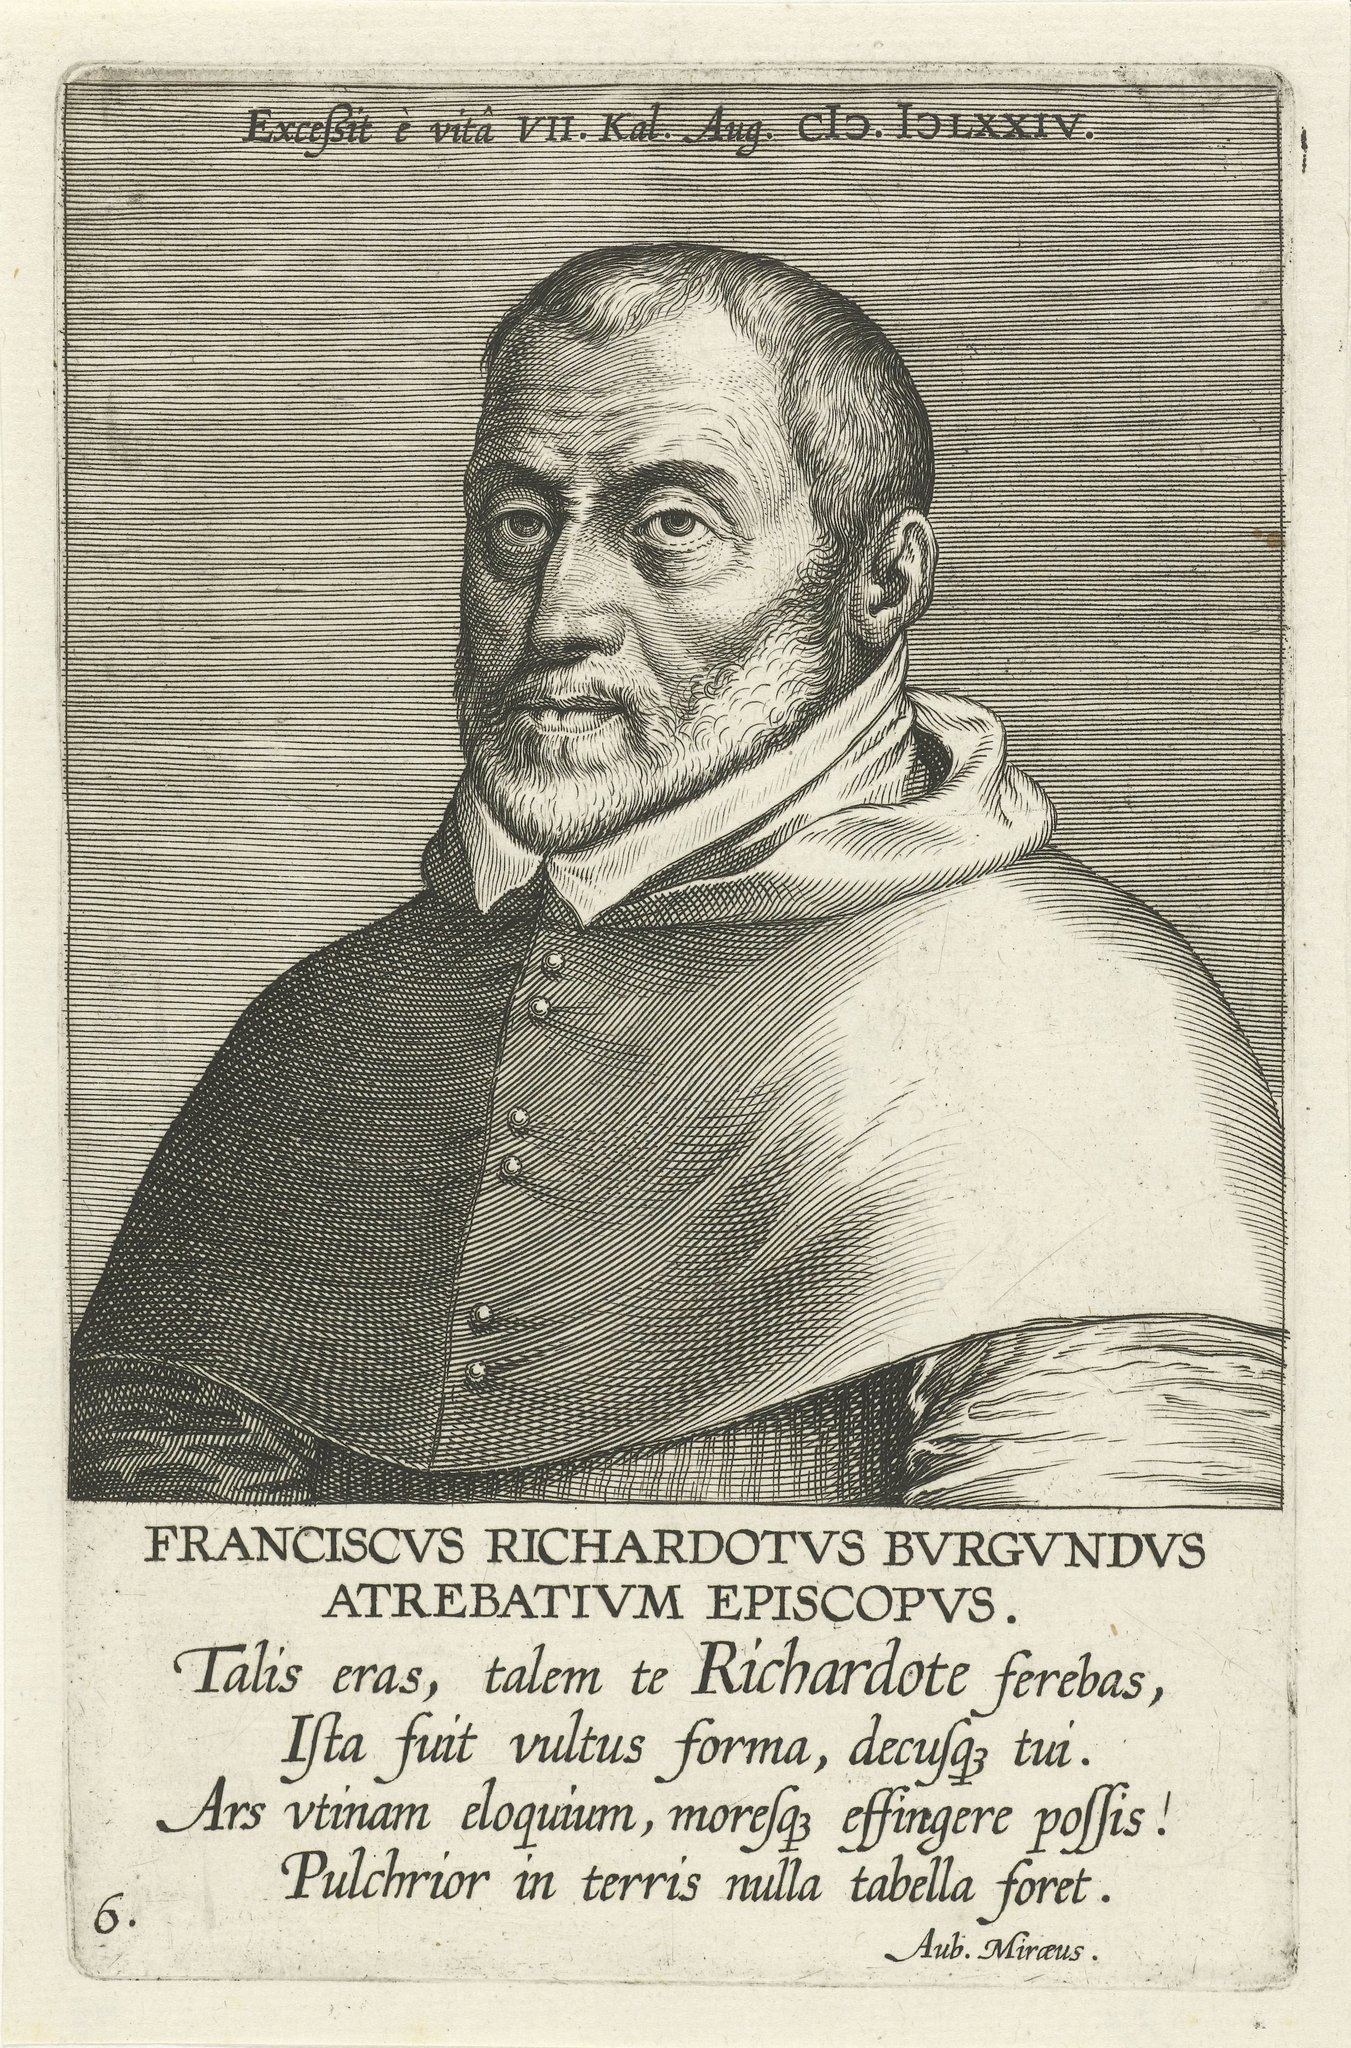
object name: print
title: Portretten van beroemde Nederlandse en Vlaamse geleerden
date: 1604-1608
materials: paper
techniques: engraving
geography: antwerp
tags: france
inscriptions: collector's mark: Lugt 2228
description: Portret van François Richardot, de Franse bisschop van Artois. Buste naar links. De prent heeft een Latijns boven- en onderschrift en maakt deel uit van een serie van beroemde Nederlandse en Vlaamse geleerden.